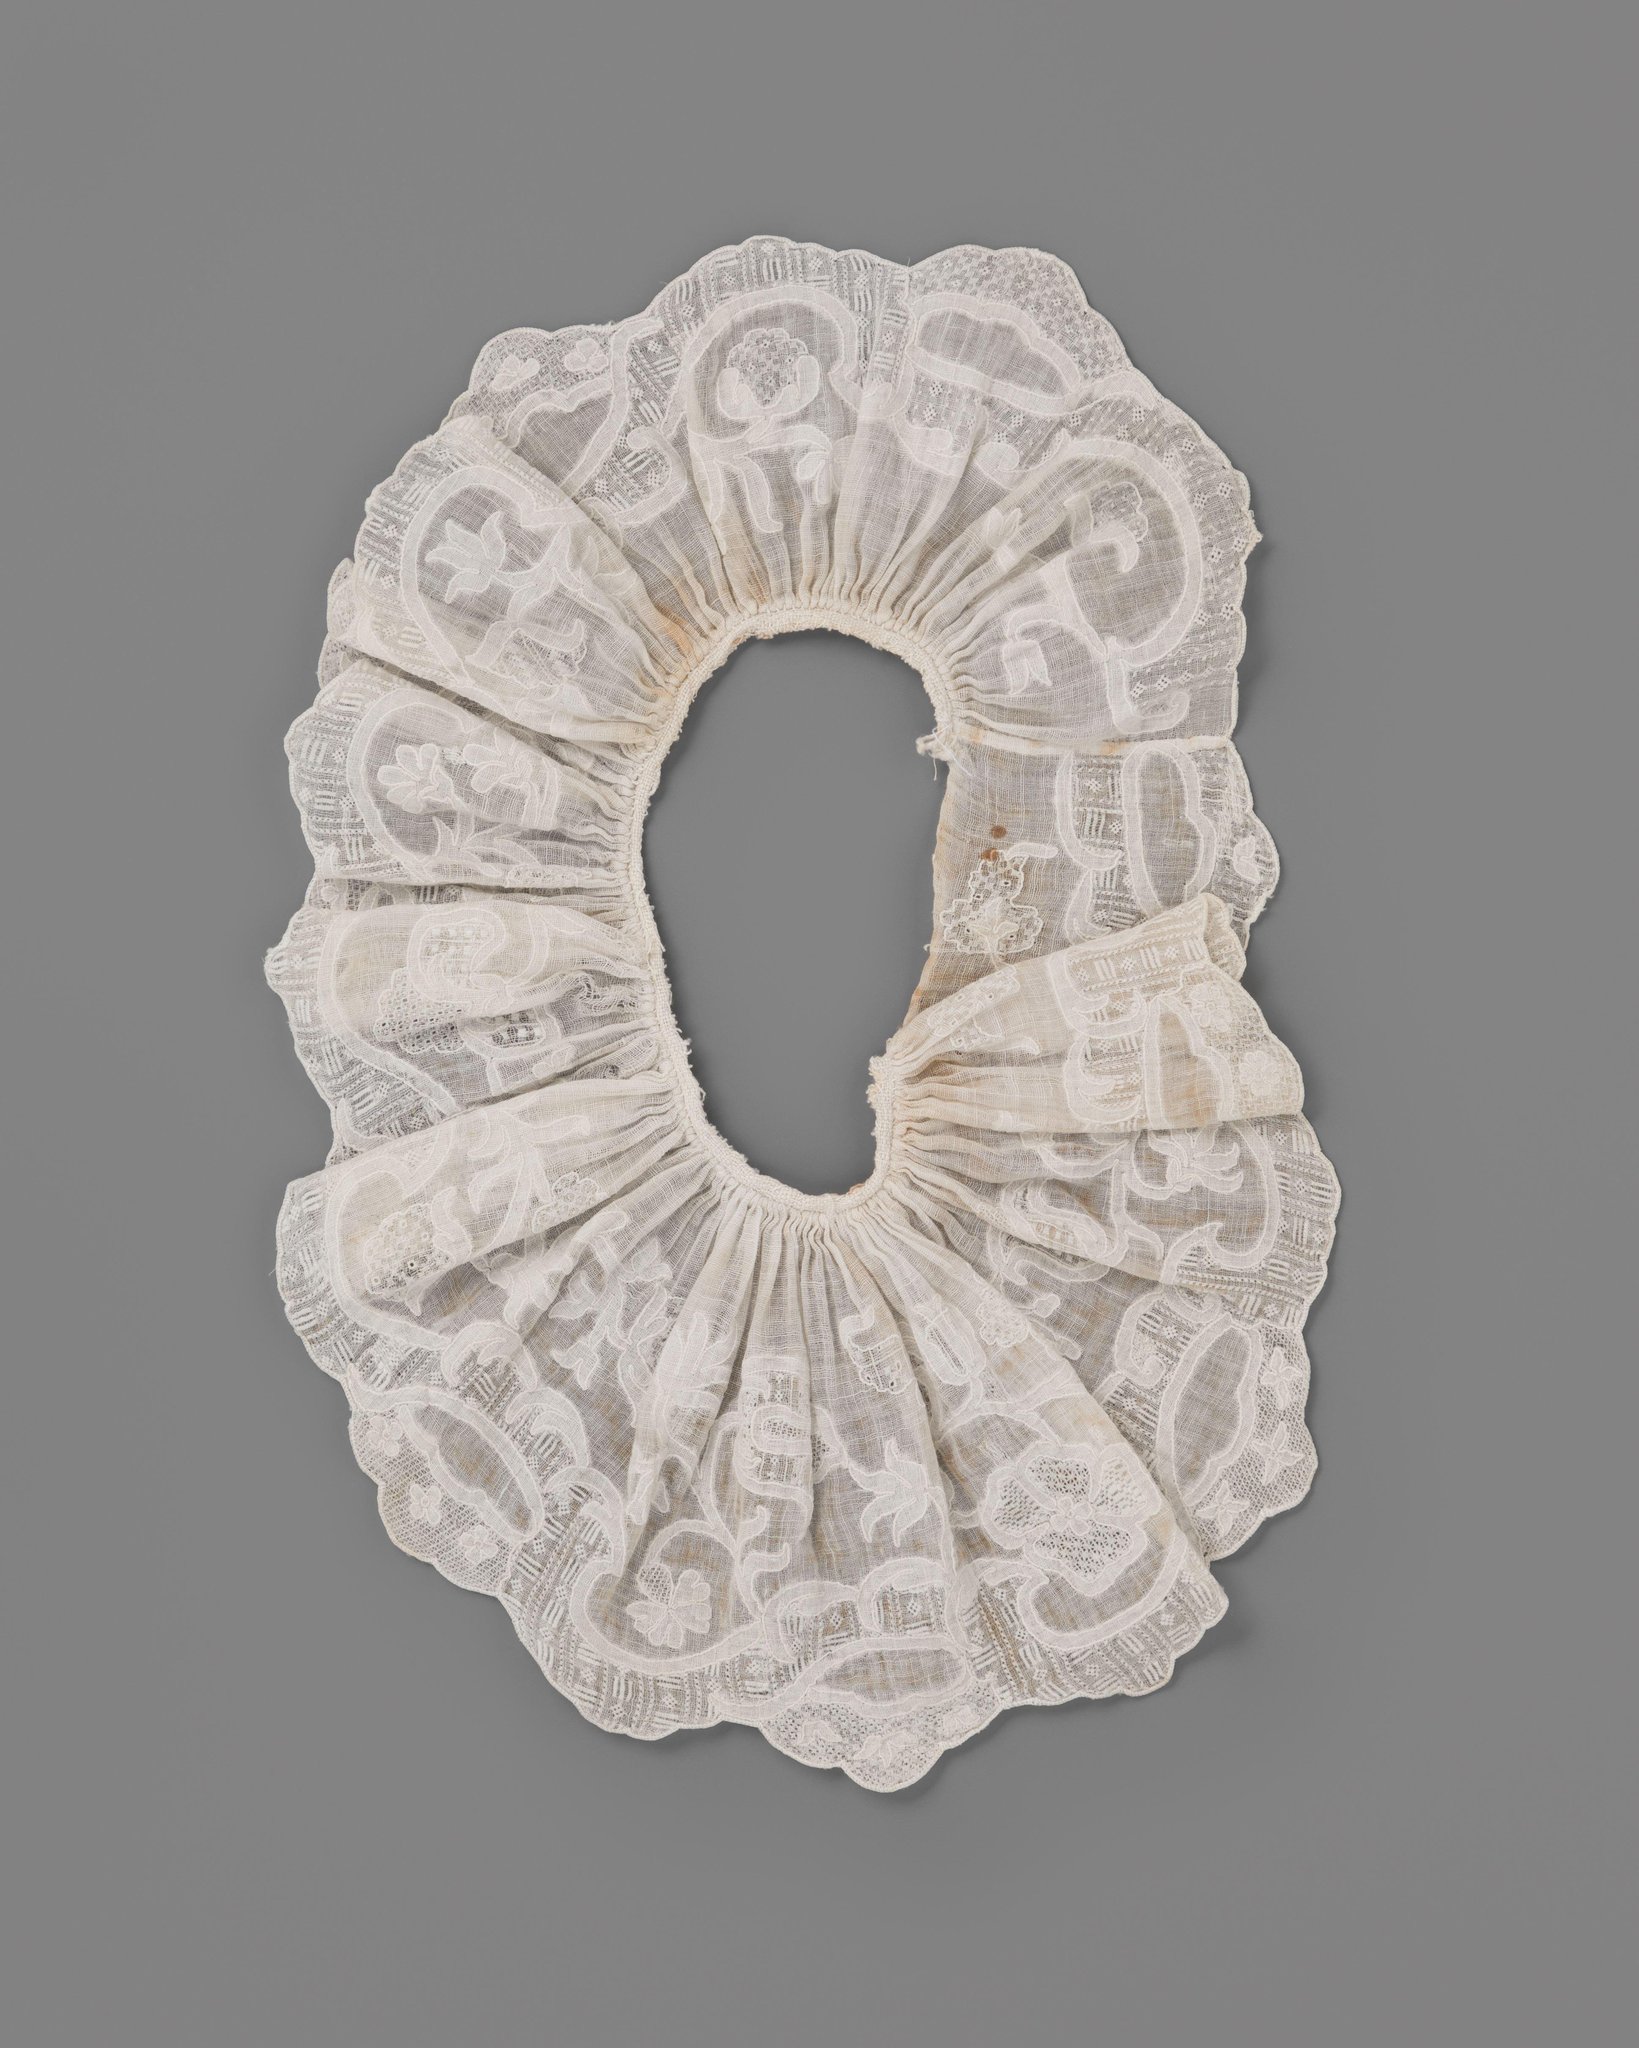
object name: womenswear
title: Manchet met florale motieven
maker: Anonymous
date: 1750-1900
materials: linen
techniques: appliqué, needle lace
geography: western europe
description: Manchet, bestaande uit drie losgetornde geschulpte lagen met florale motieven.